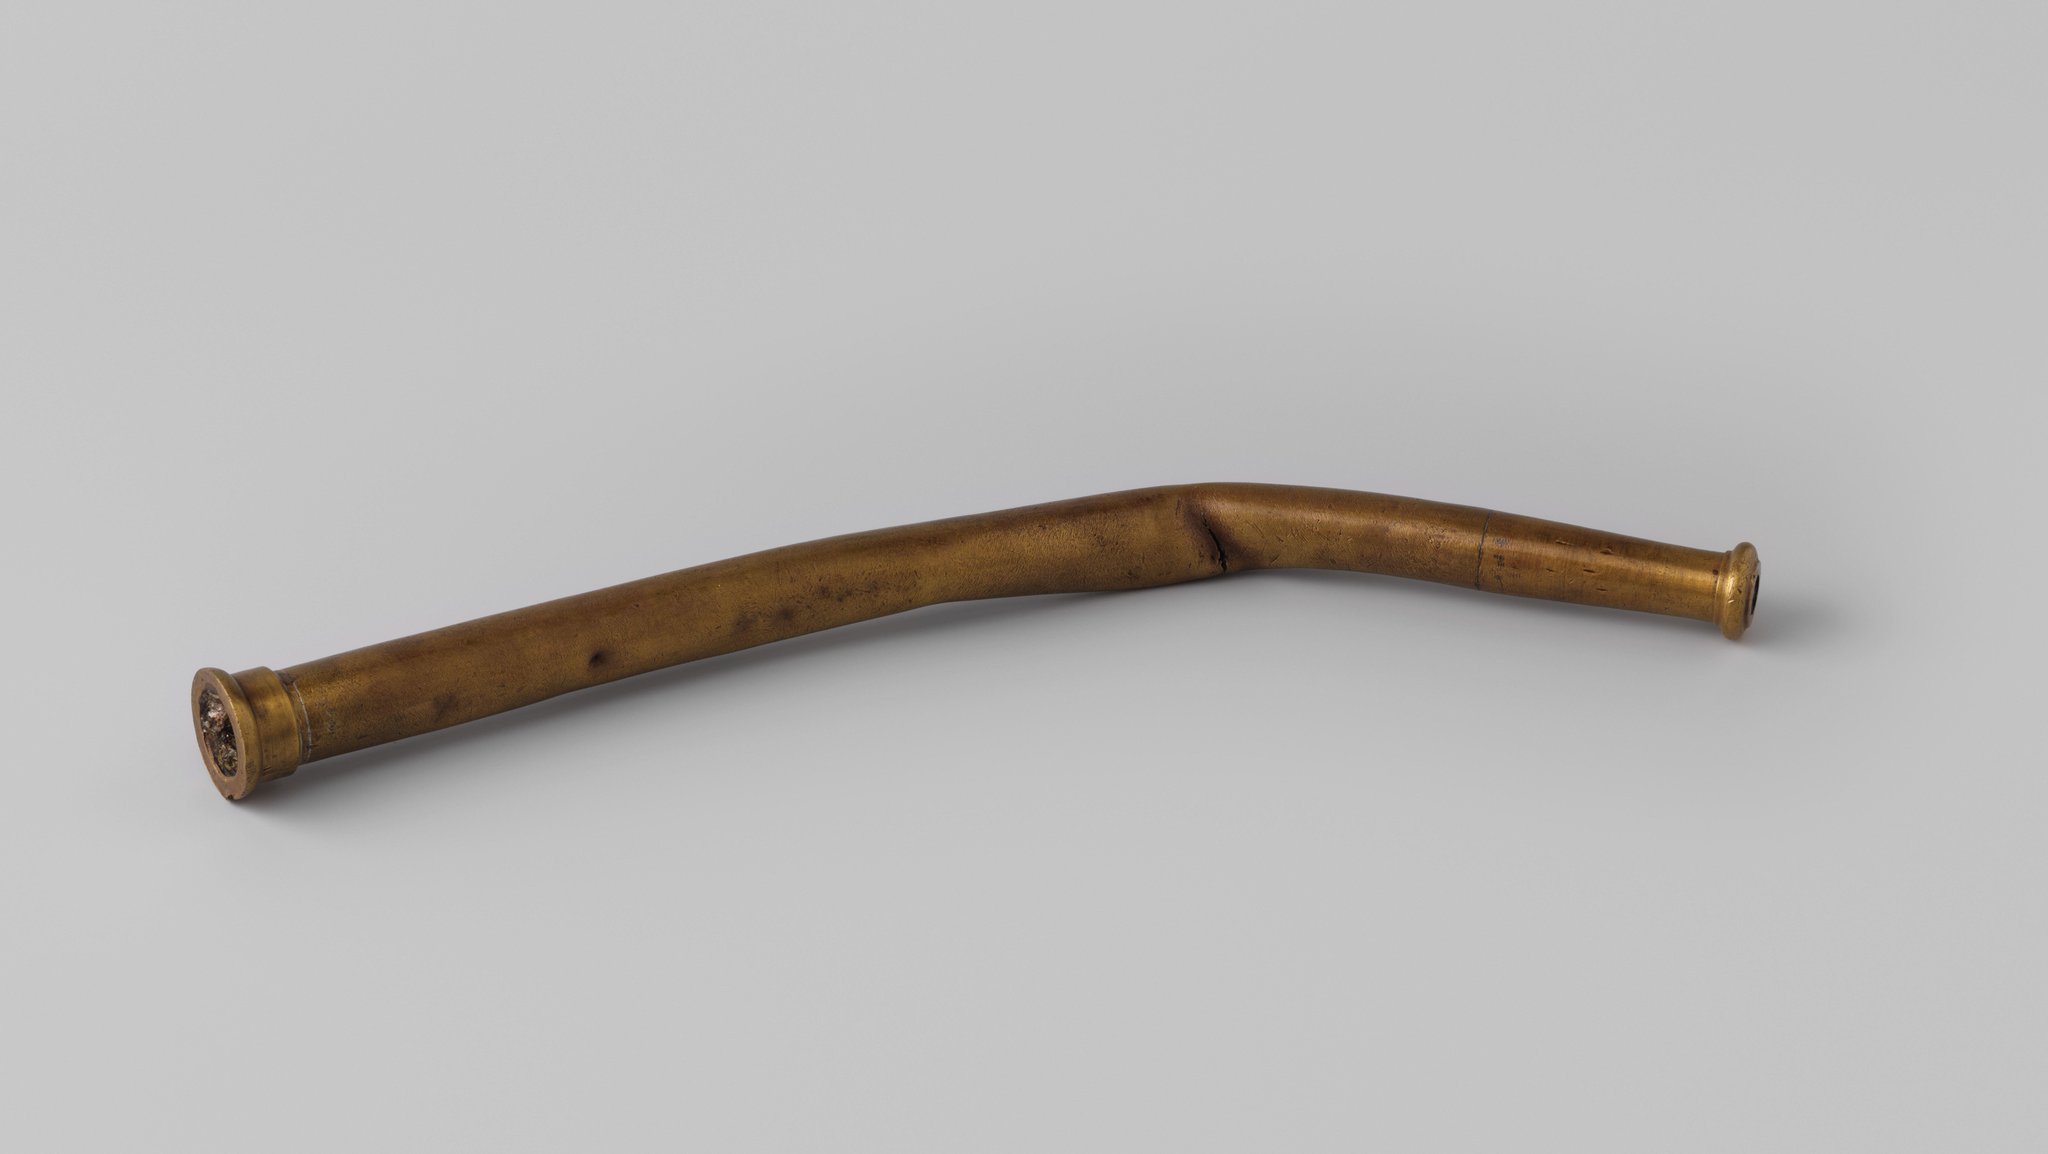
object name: firehose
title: Bronze nozzle of a firing machine from the wreck of the Dutch East Indiaman Hollandia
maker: Anonymous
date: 1700-1743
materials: copper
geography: netherlands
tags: verenigde oostindische compagnie, hollandia (schip), annet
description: Fire engine, firehose nozzle; bent, circular, tapering tube, flanged rim at upper end, integral shaped socket with flanged rim at lower end, internally threaded and fitting onto nozzle NG 1978-8H1921.